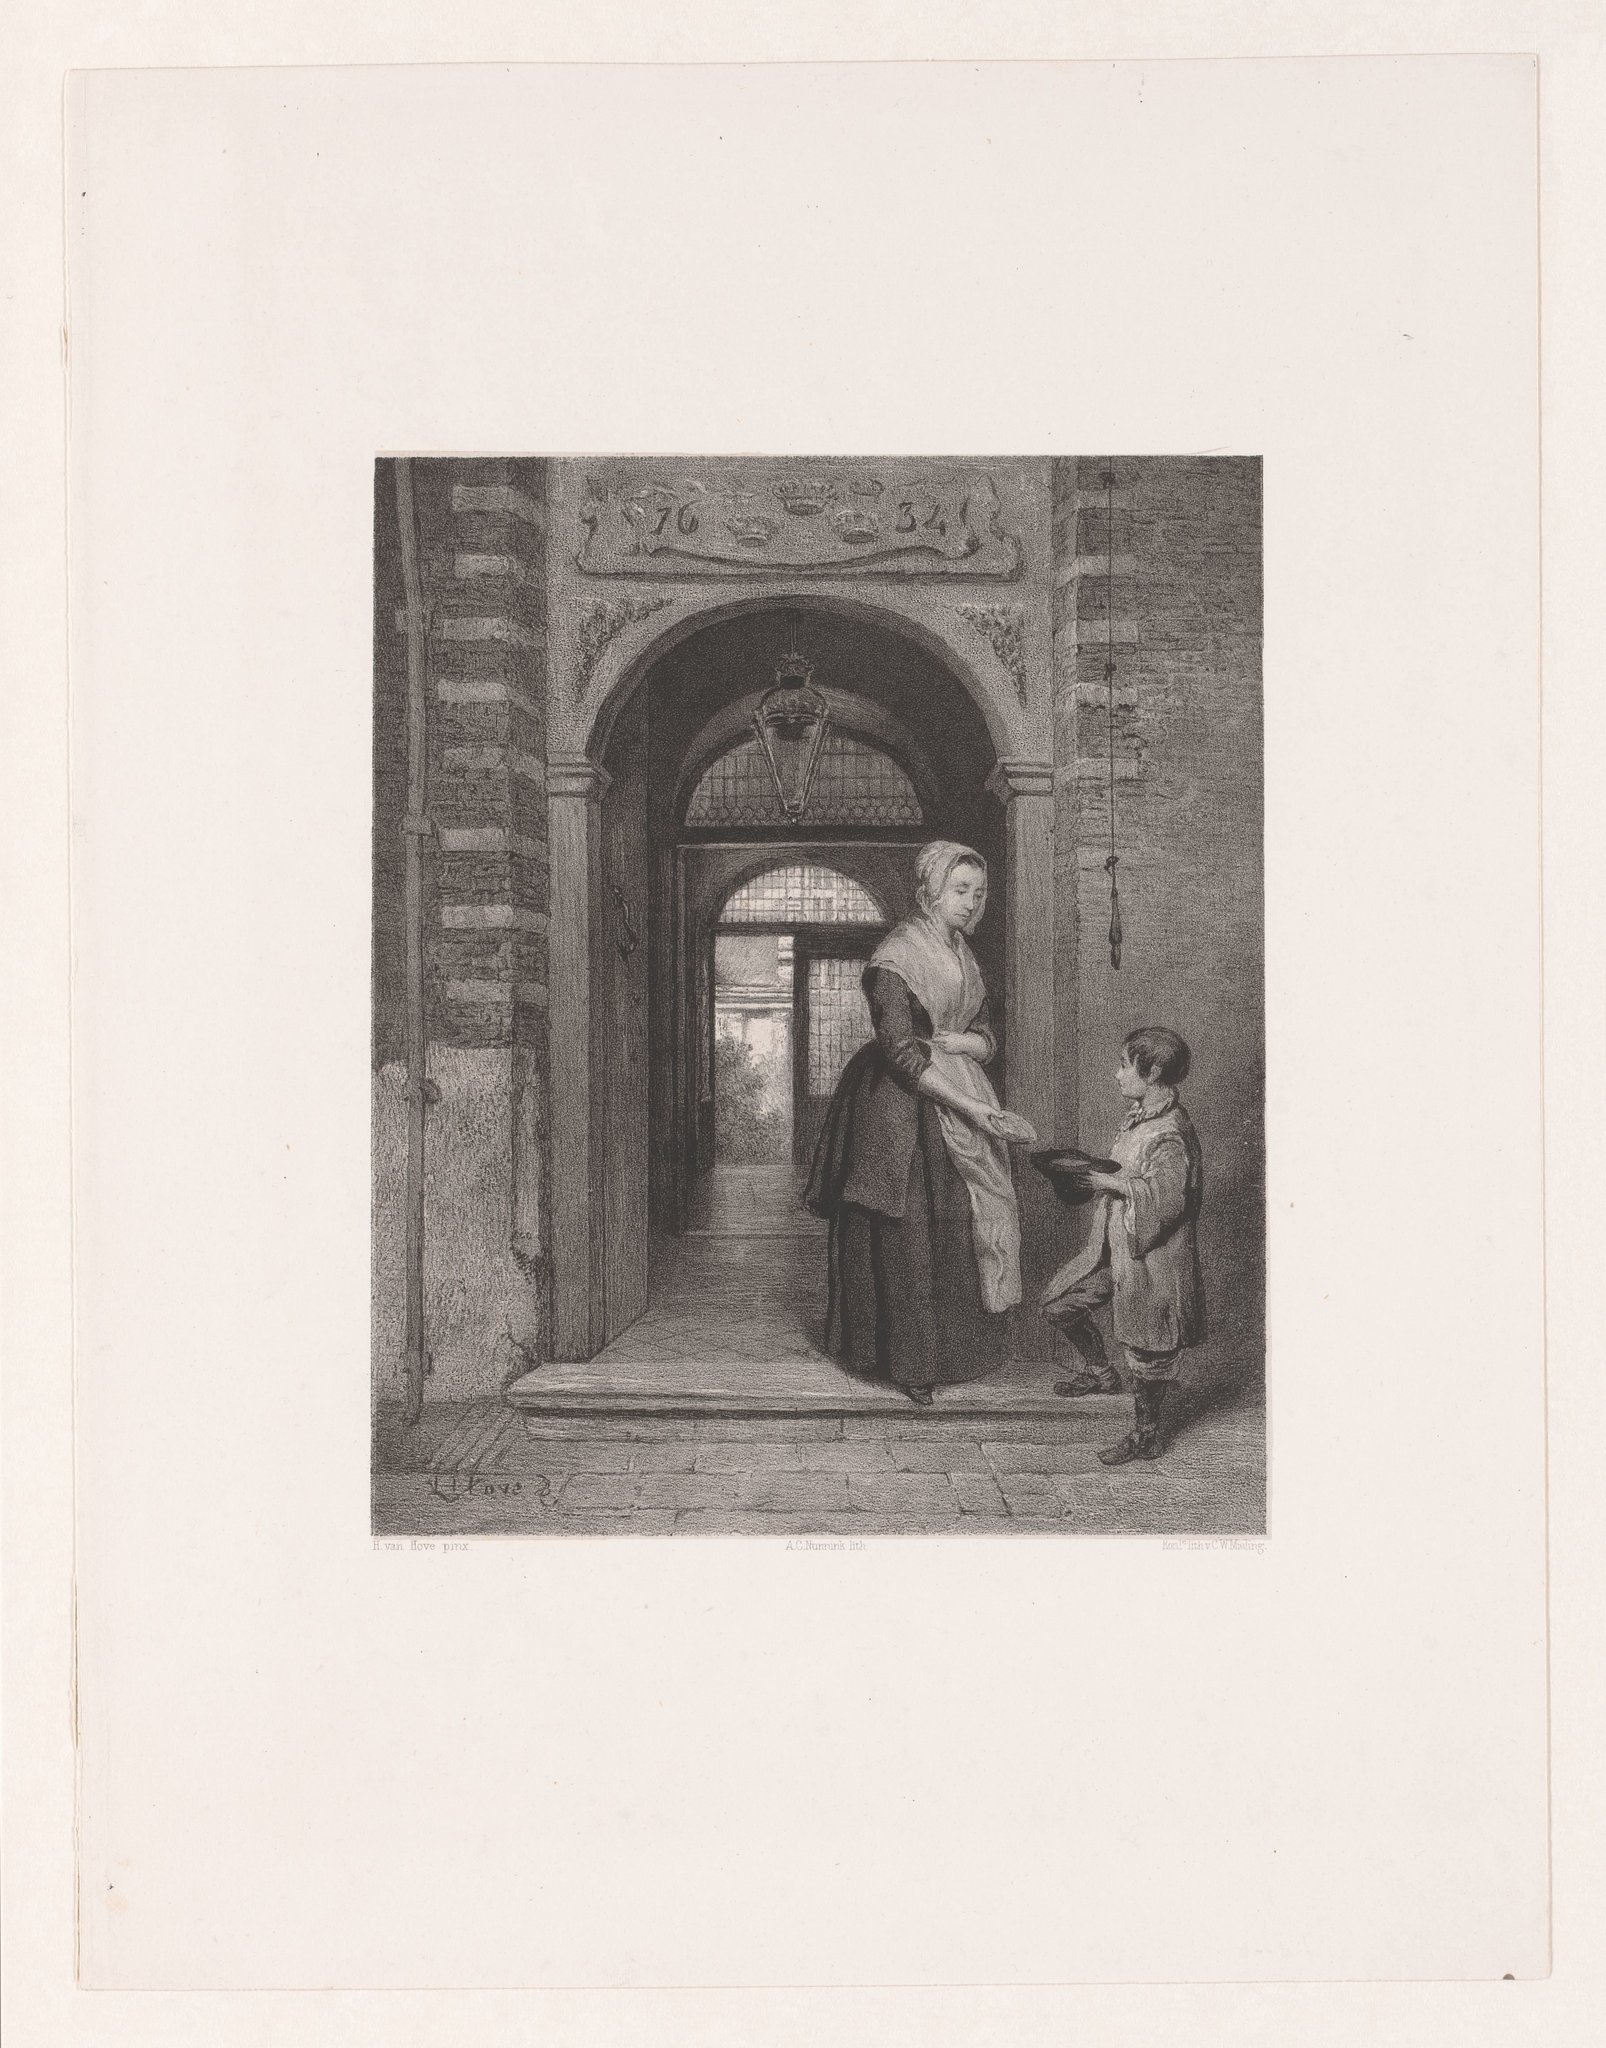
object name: print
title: Vrouw geeft bedelende jongen brood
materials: paper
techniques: lithograph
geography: the hague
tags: beggar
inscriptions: collector's mark: Lugt 2228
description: Een vrouw bij een poort die toegang geeft tot een hof, geeft een bedelende jongen brood.